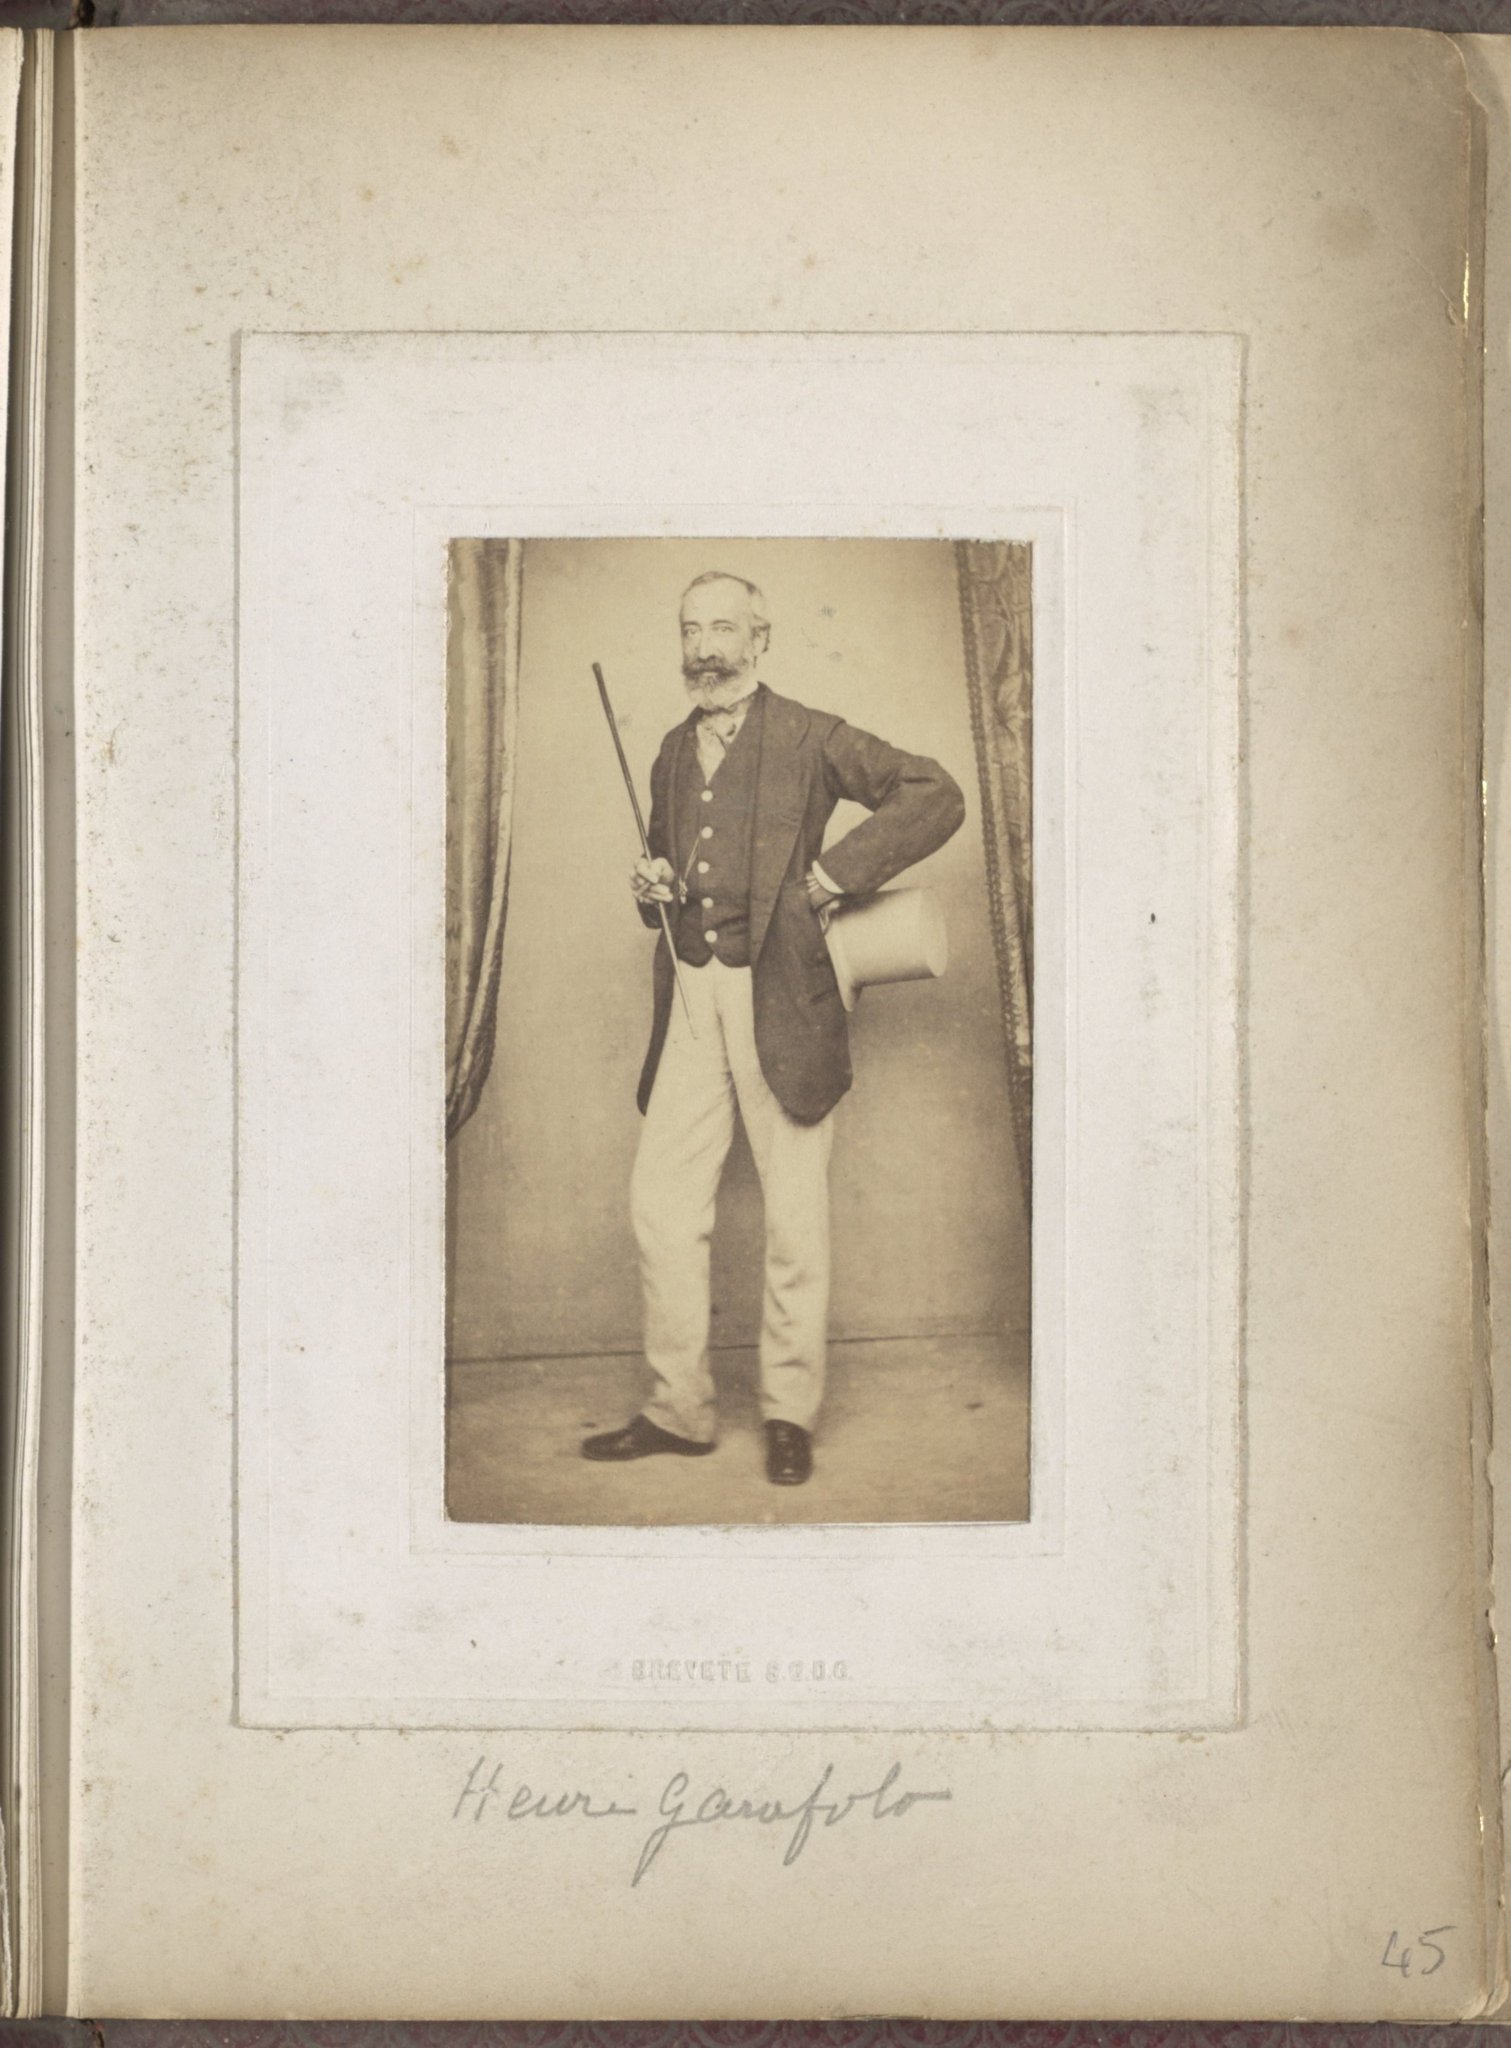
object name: carte de visite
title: Portret van Henri Garofalo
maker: alphonse bernoud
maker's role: fotograaf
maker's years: 1820-1889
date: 1860-1865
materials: cardboard, paper, photographic support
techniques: albumen print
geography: italy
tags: studio requisites ~ photographer, cigar, trousers, breeches, walking-stick, staff, historical persons, neck-gear ~ clothing, clothing for the upper part of the body, shoes, sandals, hairdress, beard, coat, cape, head-gear: top hat, italy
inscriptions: address: ‘Naples Boschetto della Villa Reale. Florence S. Maria in Camp, 434.’, name: ‘Henri Garafolo’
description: Onderdeel van Fotoalbum met 48 cartes-de-visite aangeboden aan maarschalk graaf De Castellane.